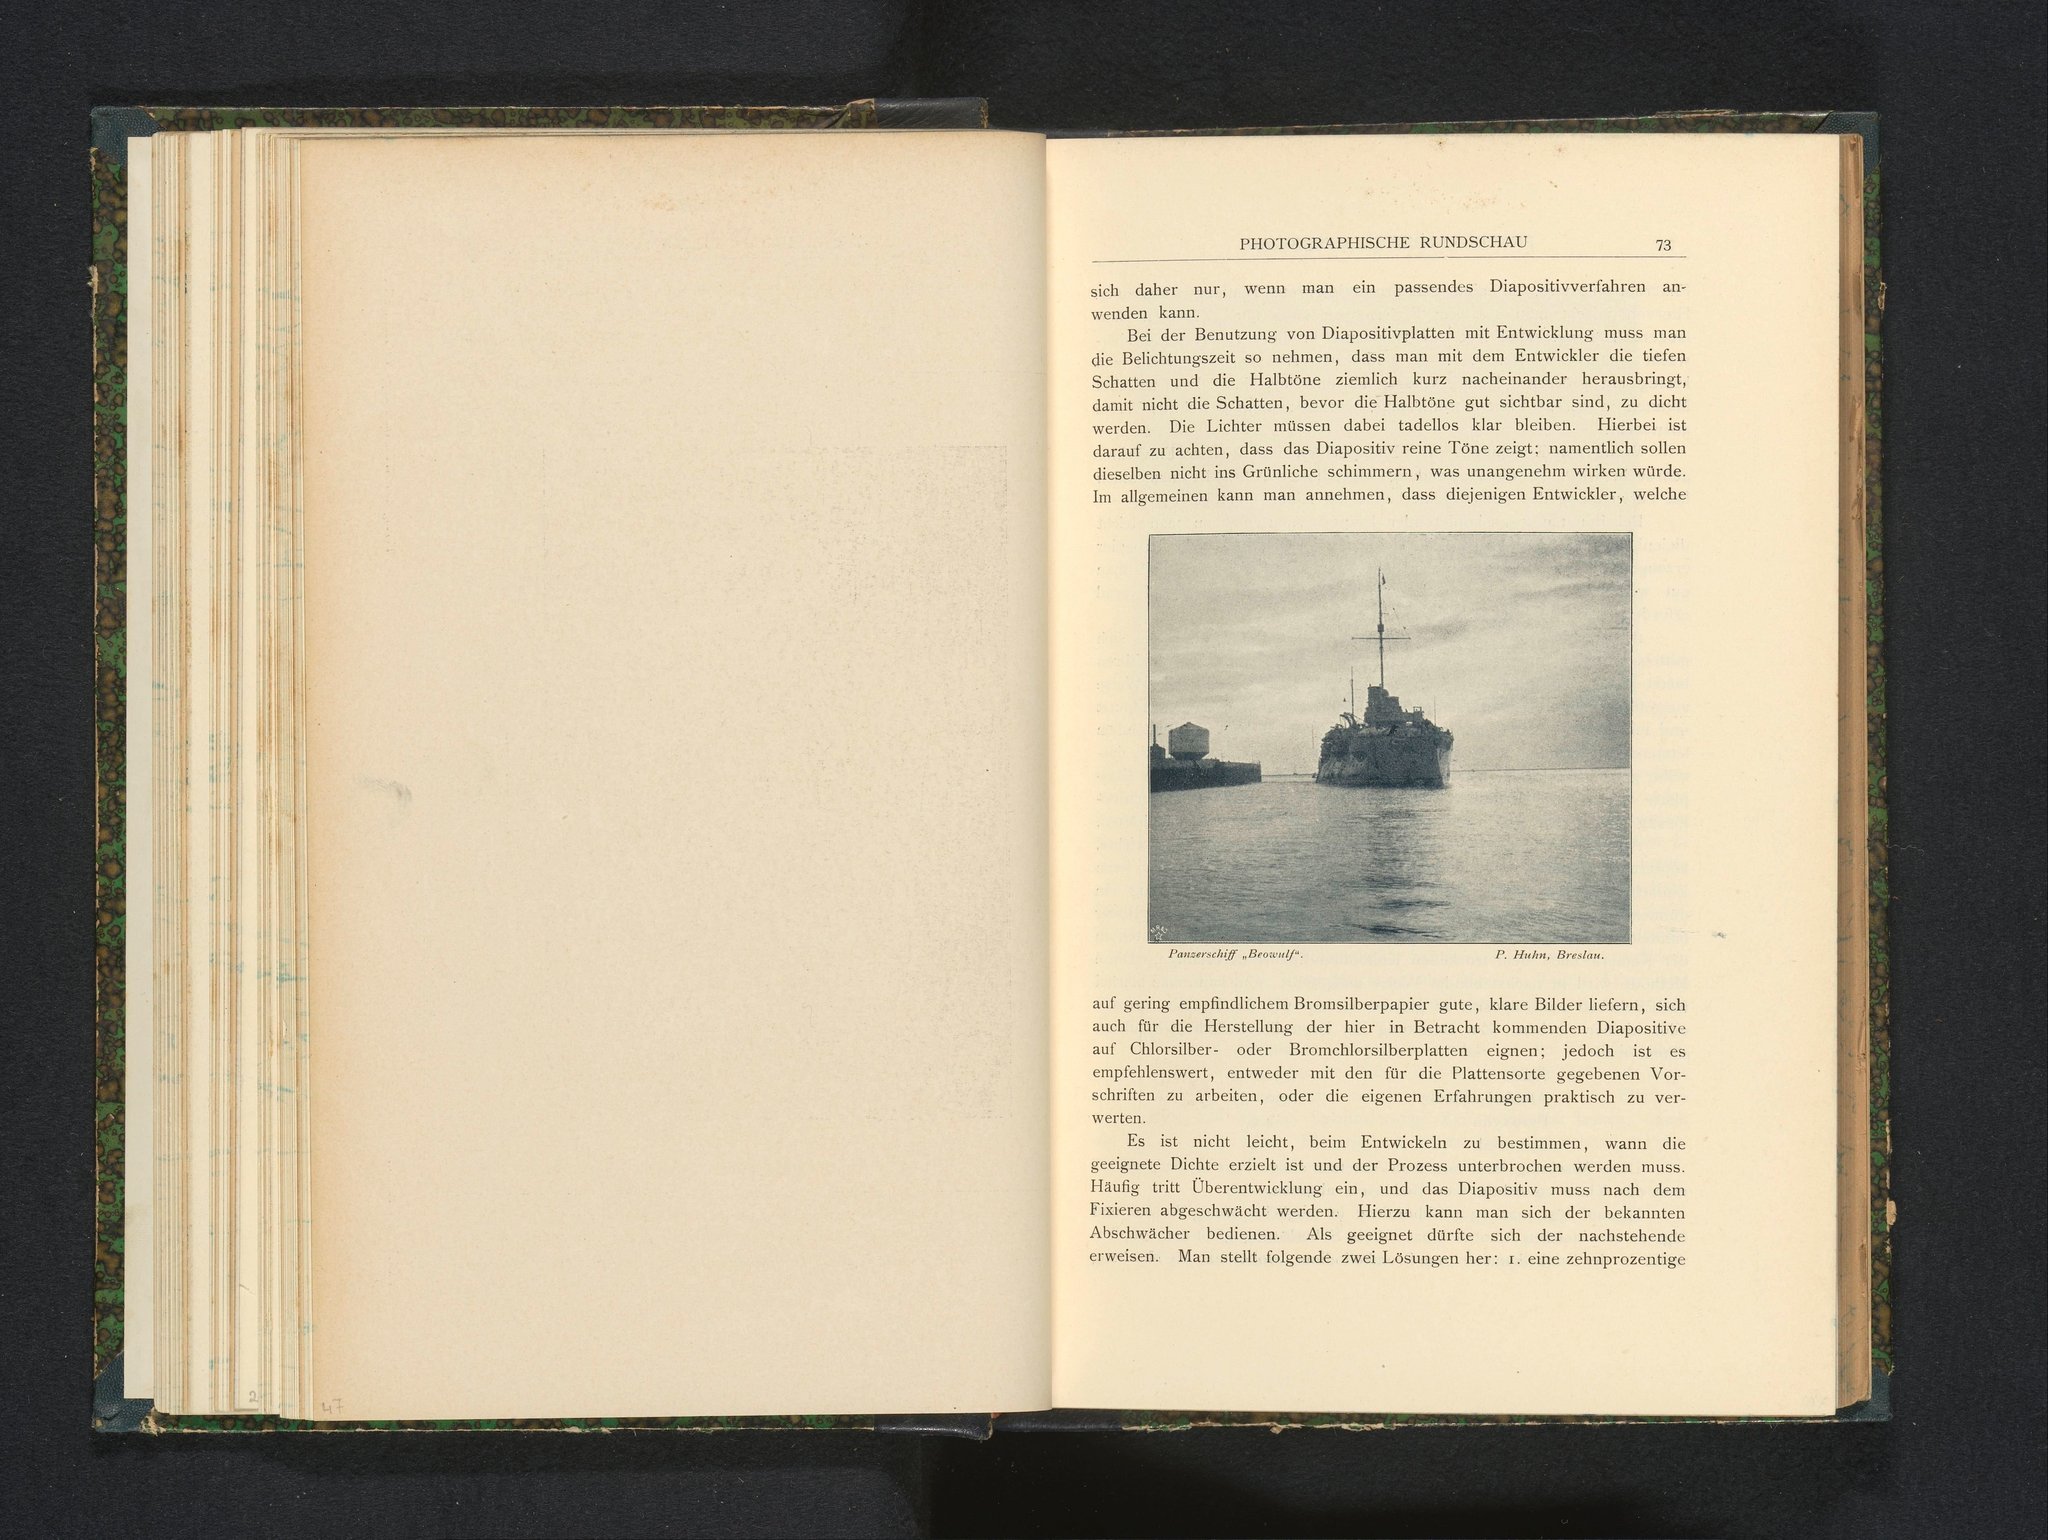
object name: photomechanical print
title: Panzerschiff "Beowulf"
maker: p. huhn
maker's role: fotograaf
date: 1894-1899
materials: paper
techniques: autotype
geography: berlin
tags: sculptor at work